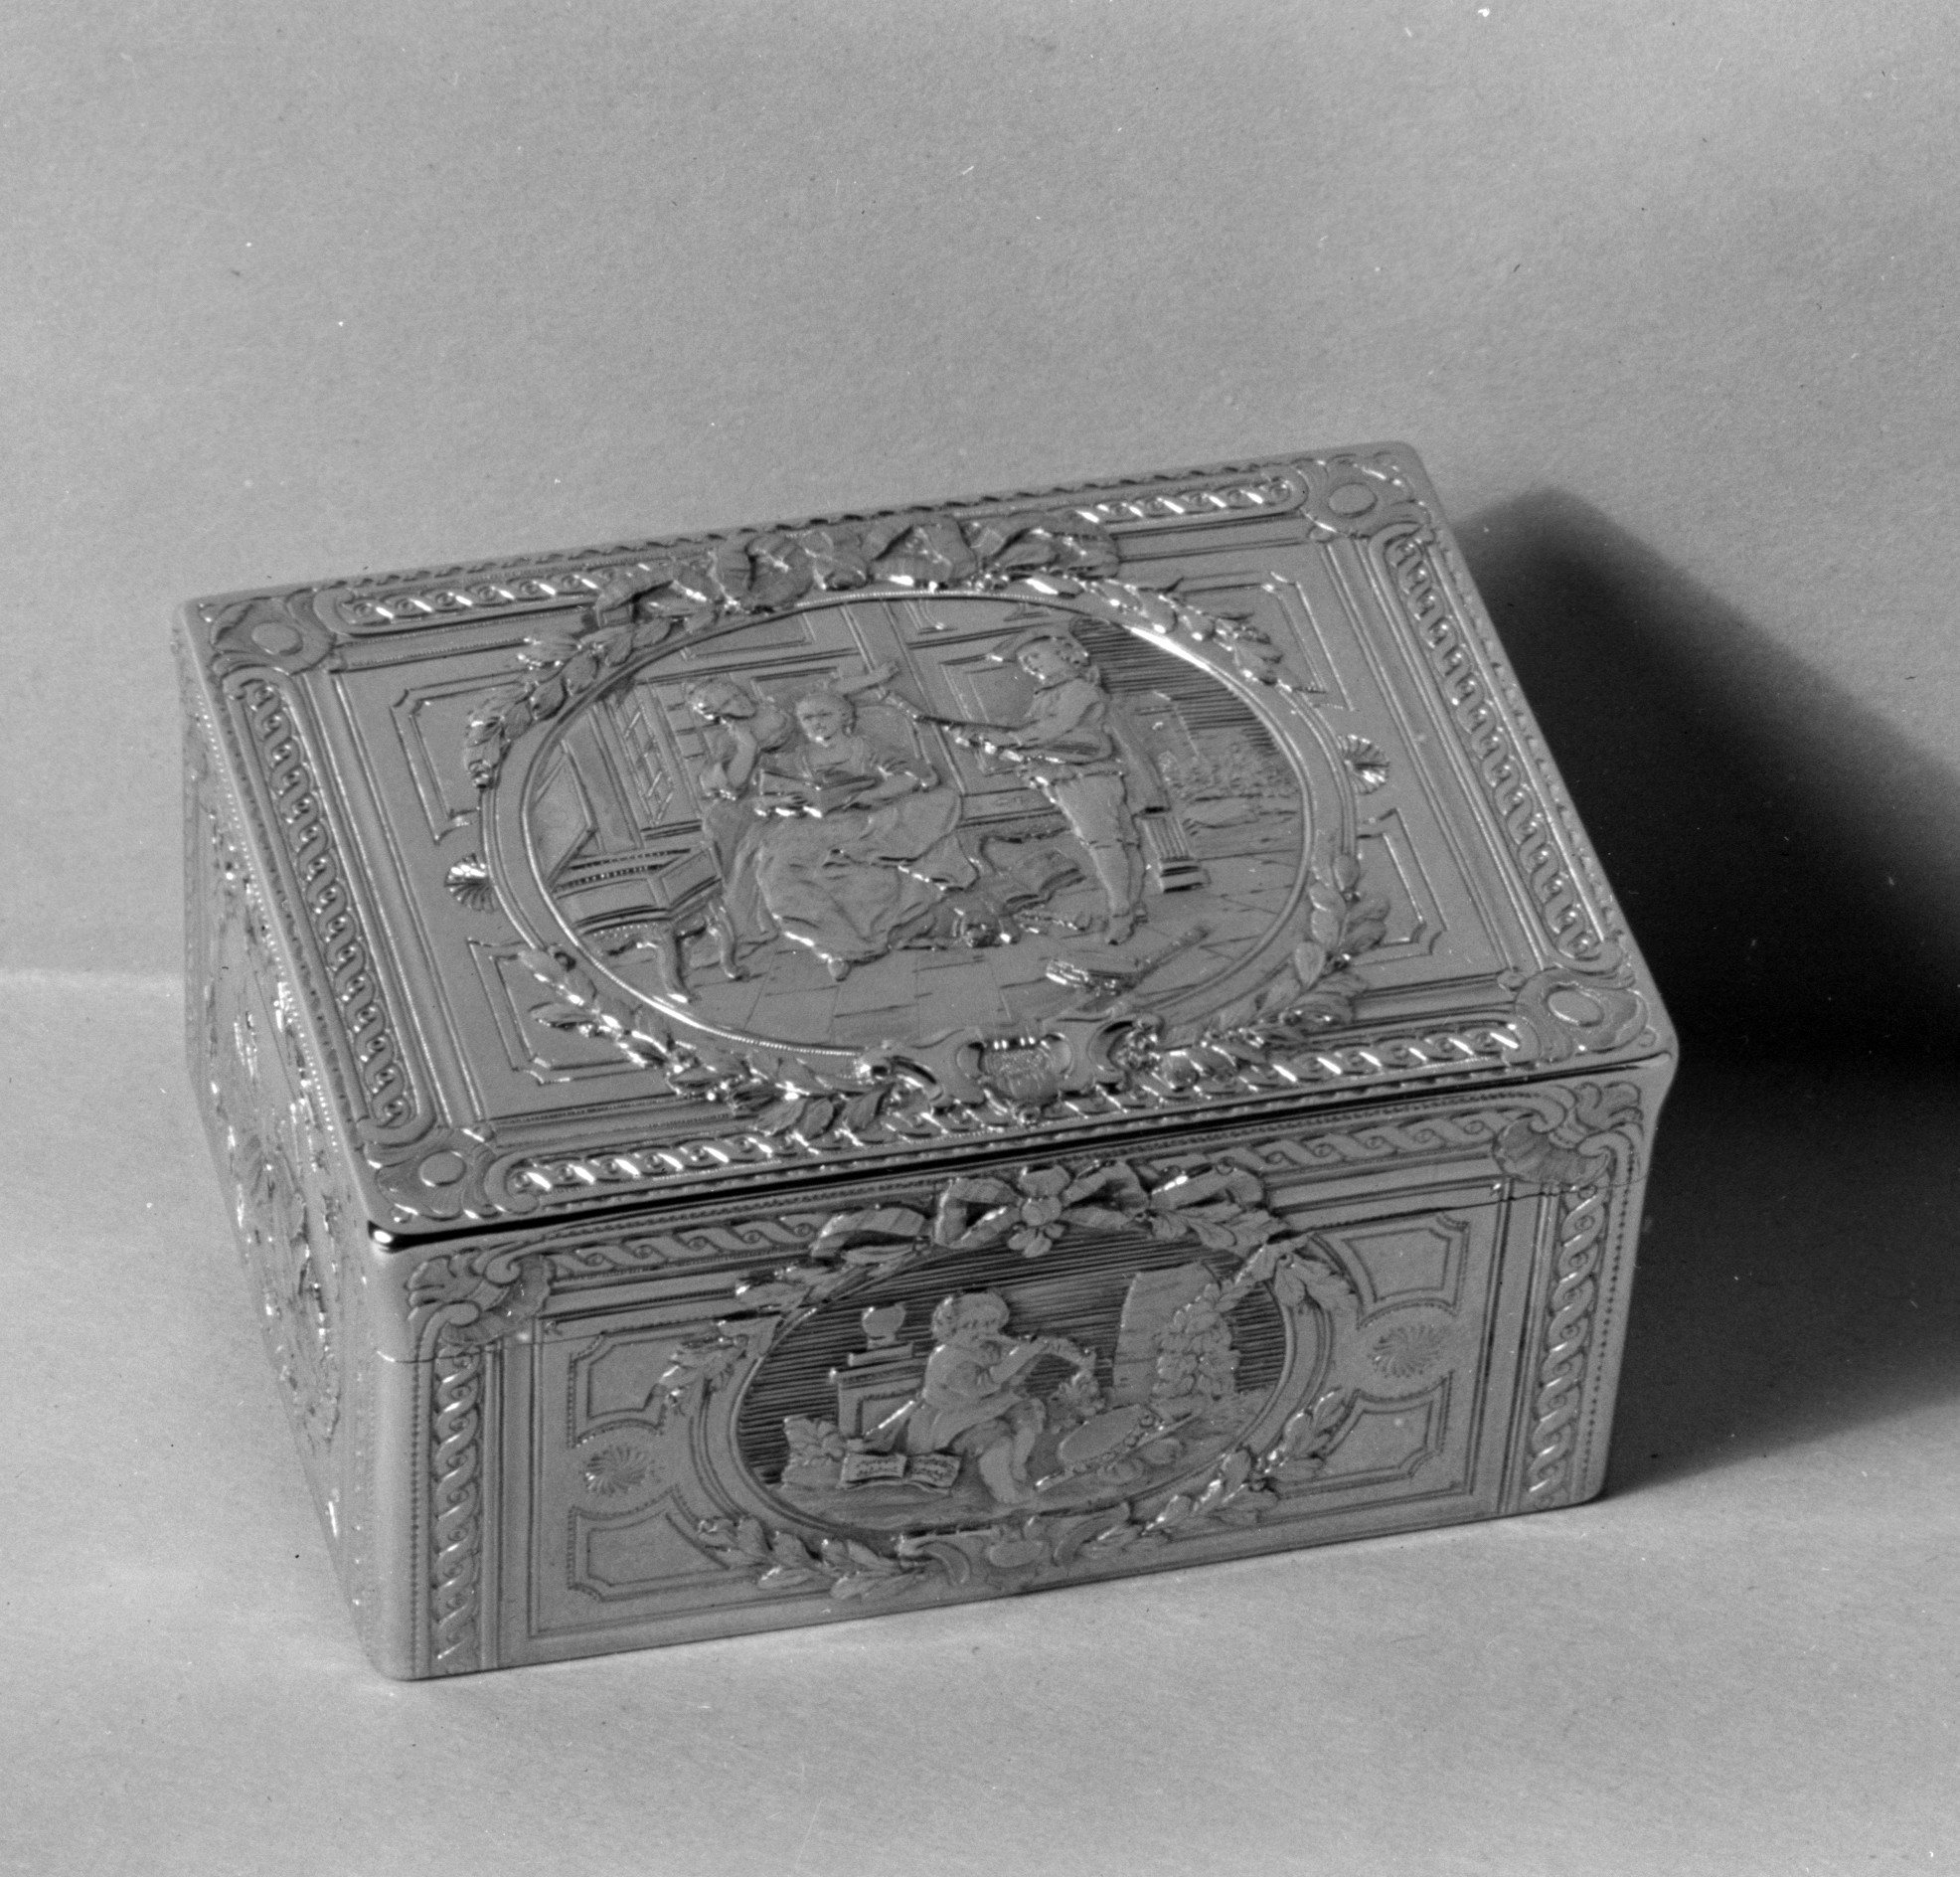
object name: snuffbox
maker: paul robert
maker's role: maker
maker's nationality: french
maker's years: 1720-1779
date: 1762-1763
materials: gold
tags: human figures